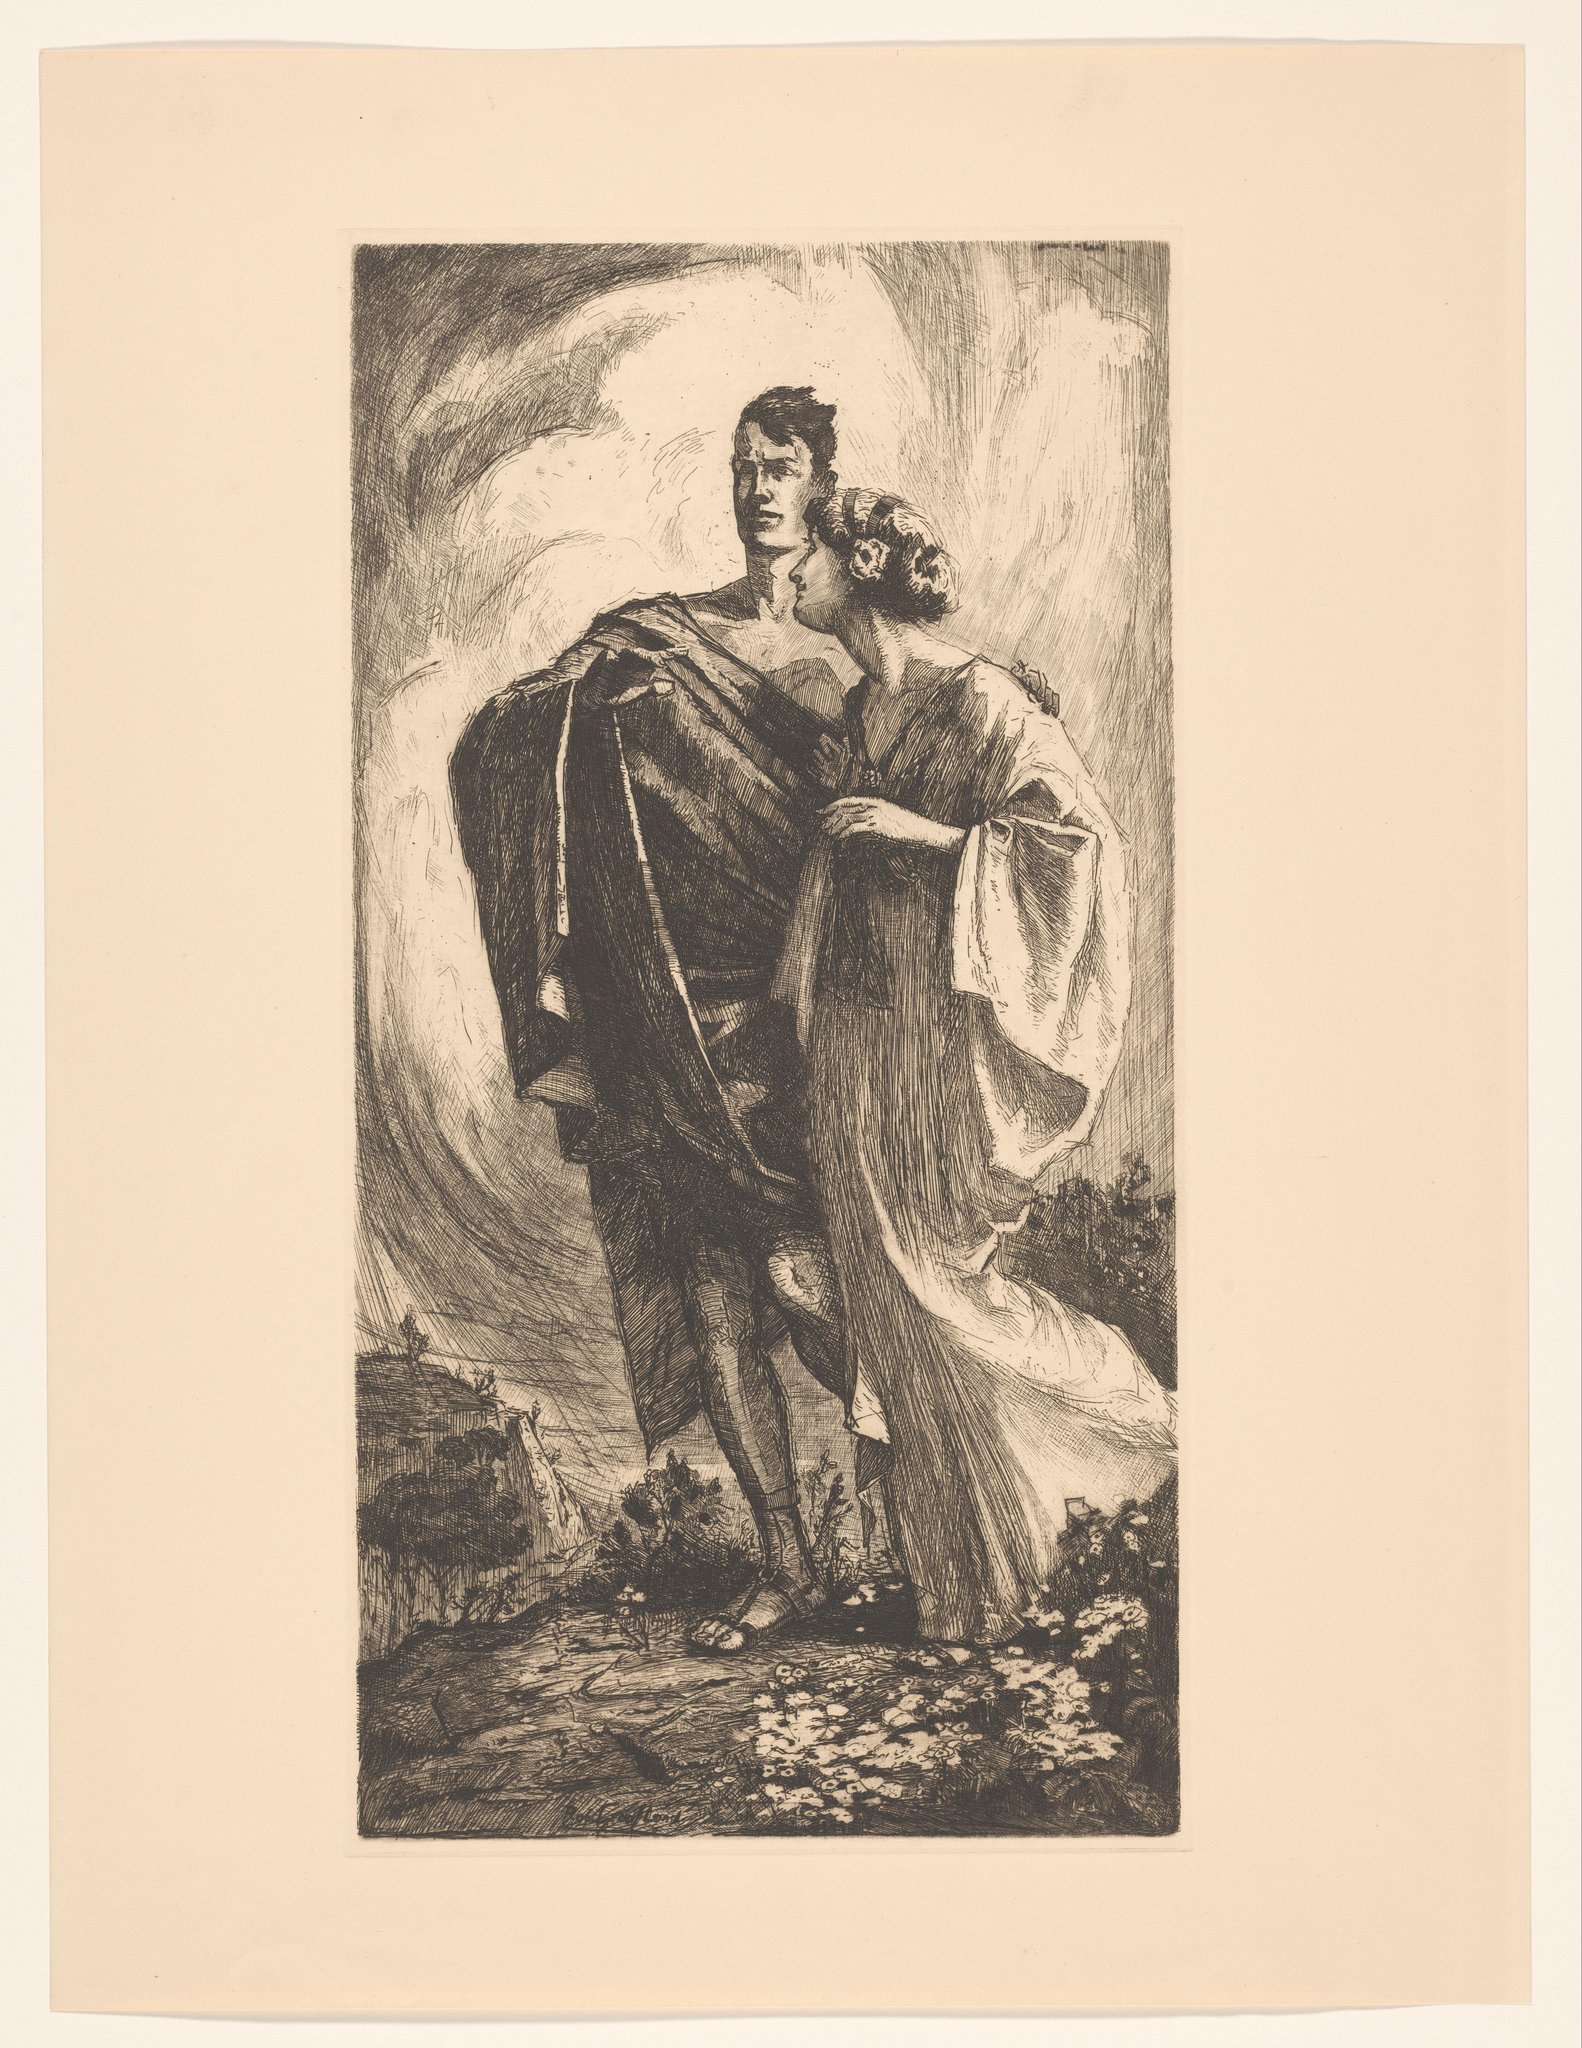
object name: print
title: Levensgang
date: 1936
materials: paper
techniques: etching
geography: den bosch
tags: female sex; woman, adult man, walking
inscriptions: collector's mark: Lugt 2228